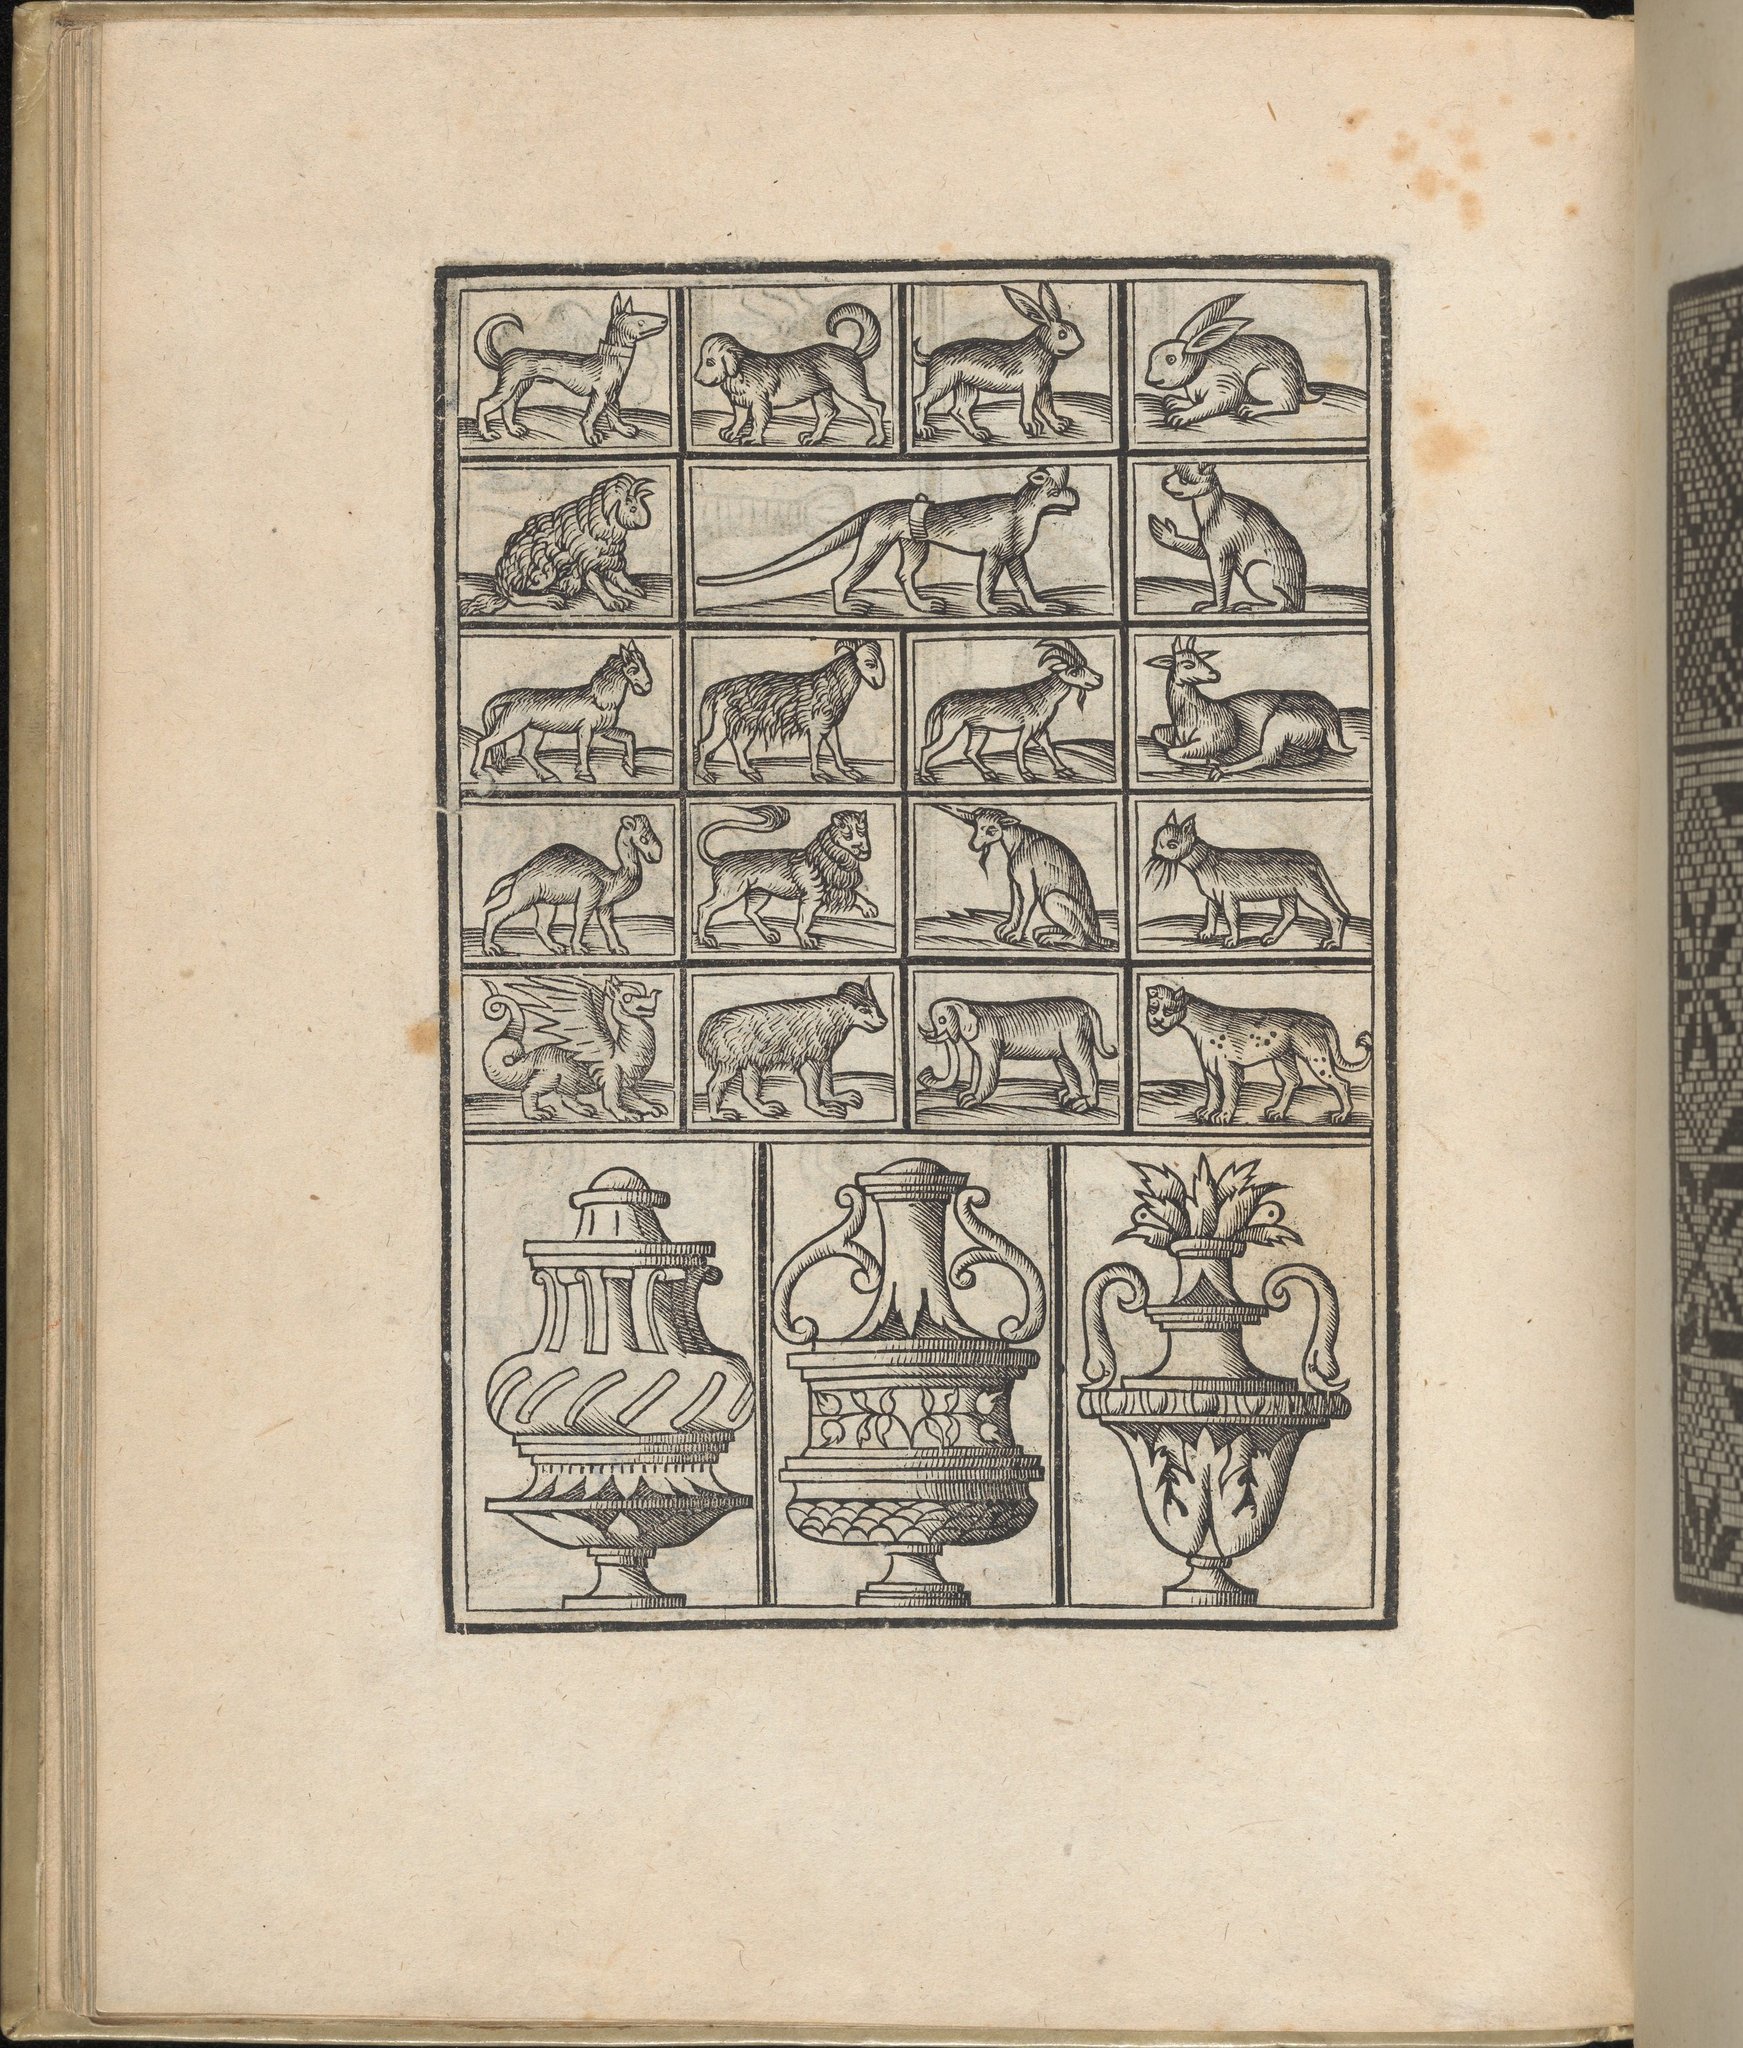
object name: book print ornament architecture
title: Trionfo Di Virtu. Libro Novo..., page 24 (recto)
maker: matteo pagano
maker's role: publisher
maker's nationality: italian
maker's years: 1515-1588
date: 1563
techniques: woodcut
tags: dragons,camels,cats,deer,dogs,goats,horses,lions,monkeys,rabbits,sheep,urns,vases